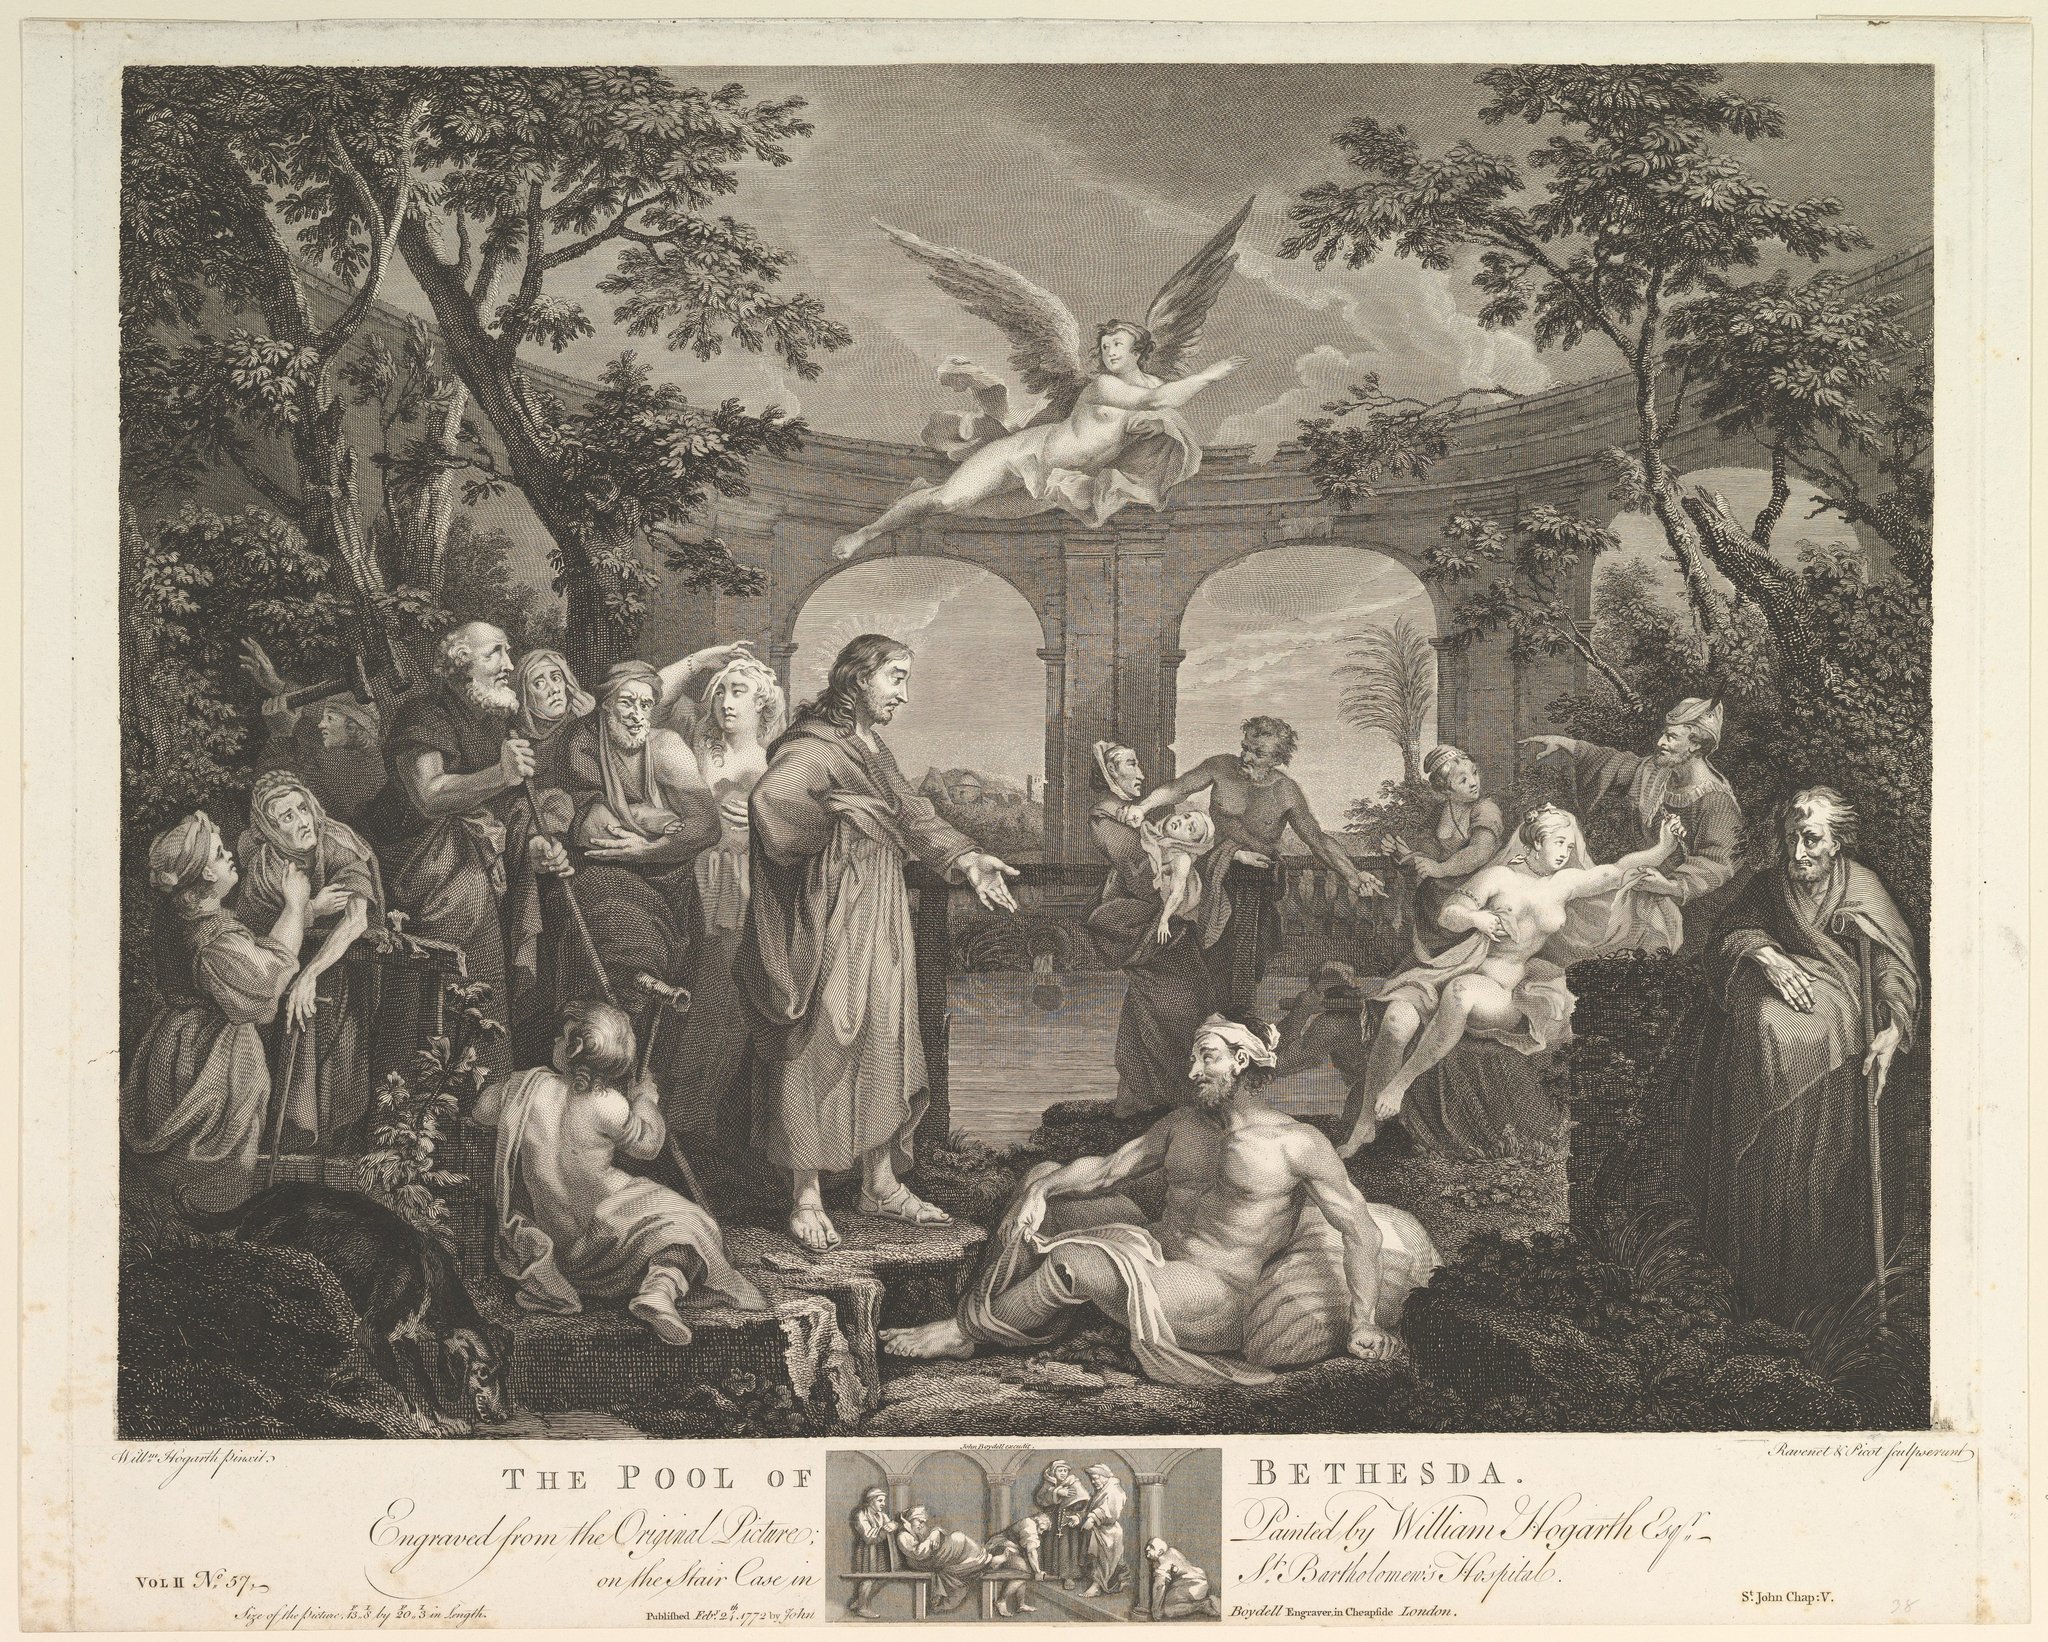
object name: print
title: The Pool of Bethesda (St. John, Chapter 5)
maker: william hogarth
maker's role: artist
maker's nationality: british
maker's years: 1697-1764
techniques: engraving, etching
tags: men,women,angels,saint john the baptist,jesus